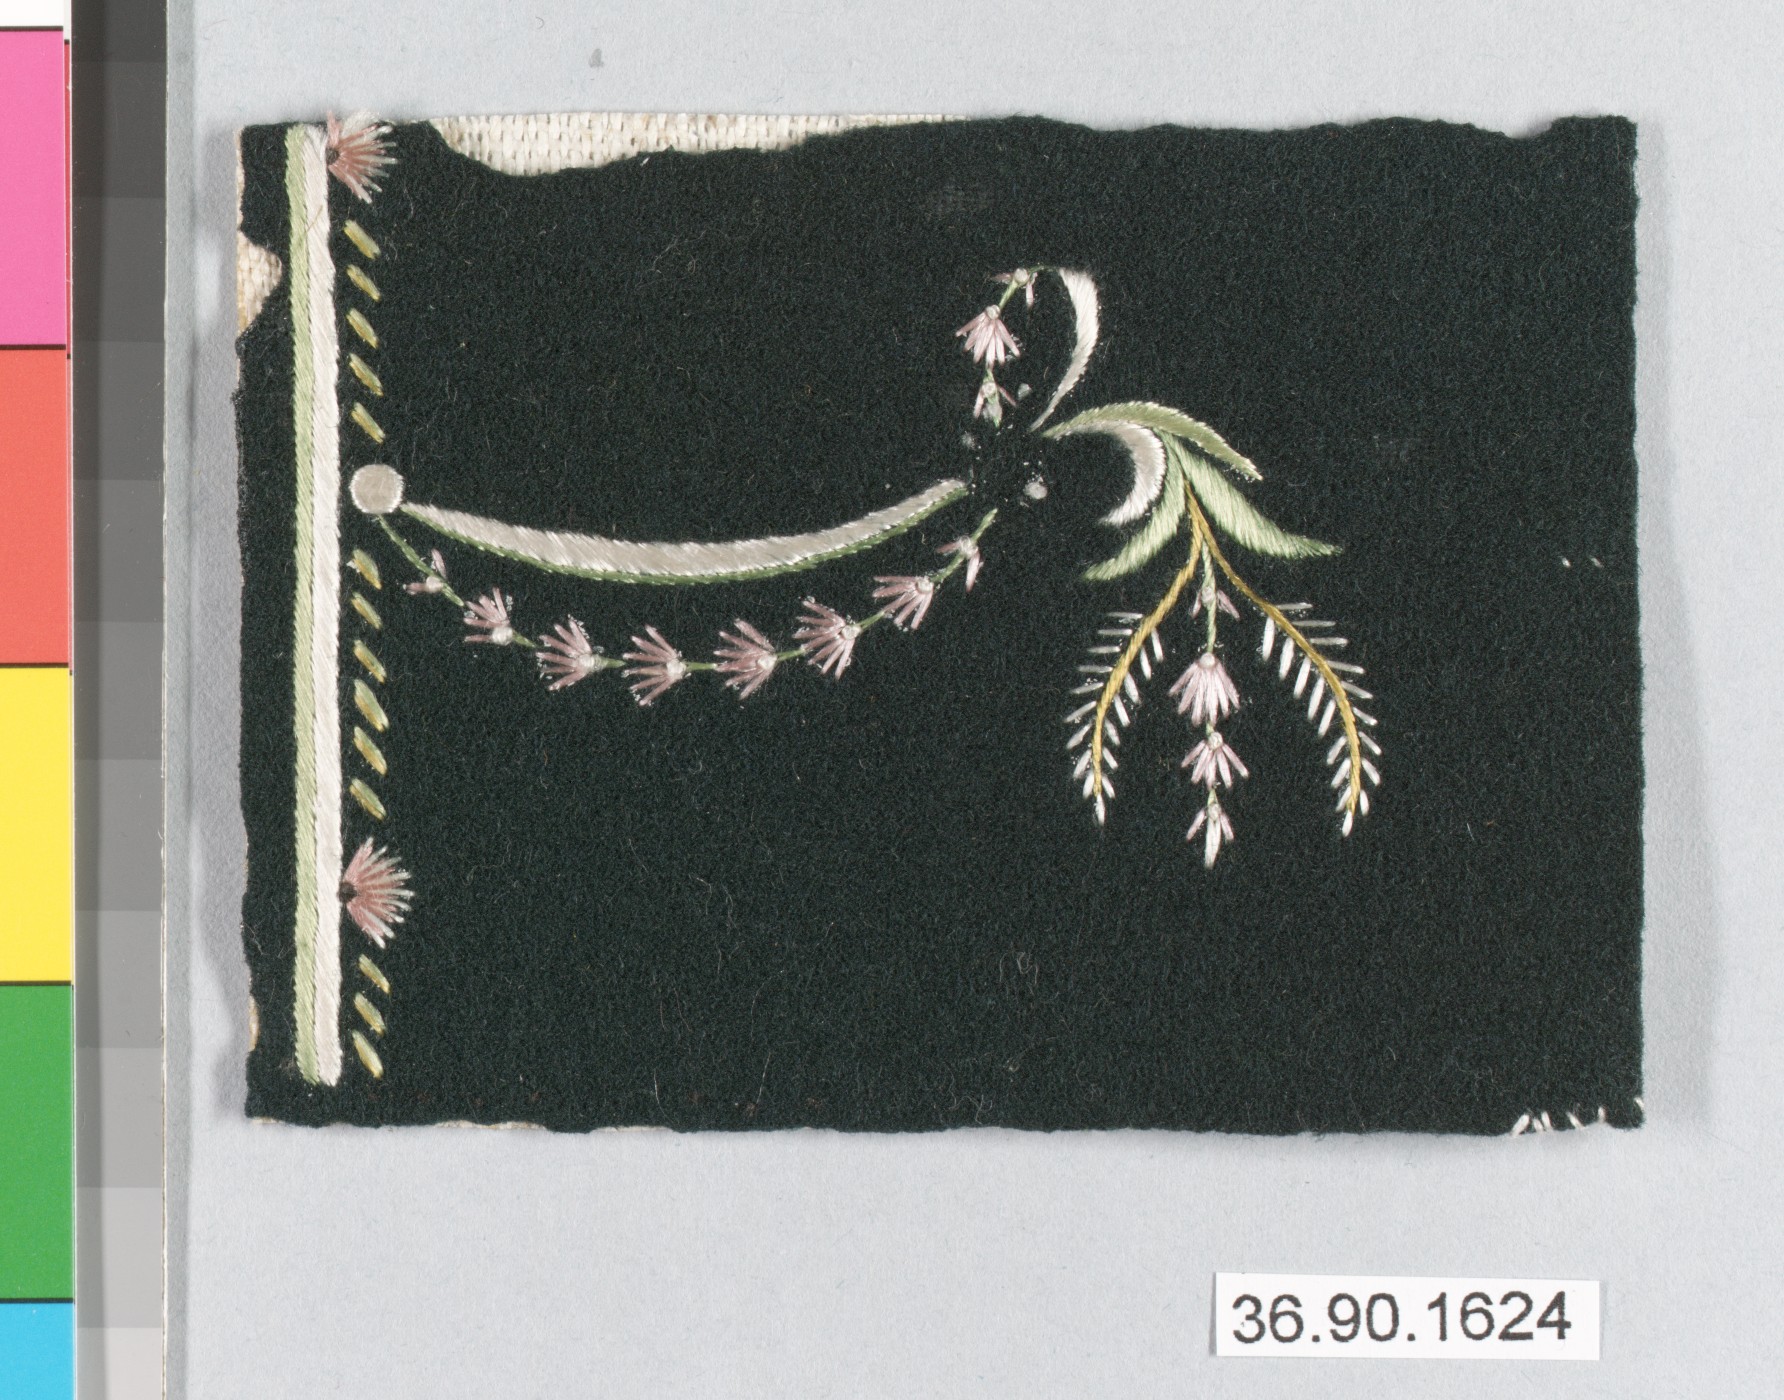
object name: sample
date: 1801-1833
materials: felt, silk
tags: plants